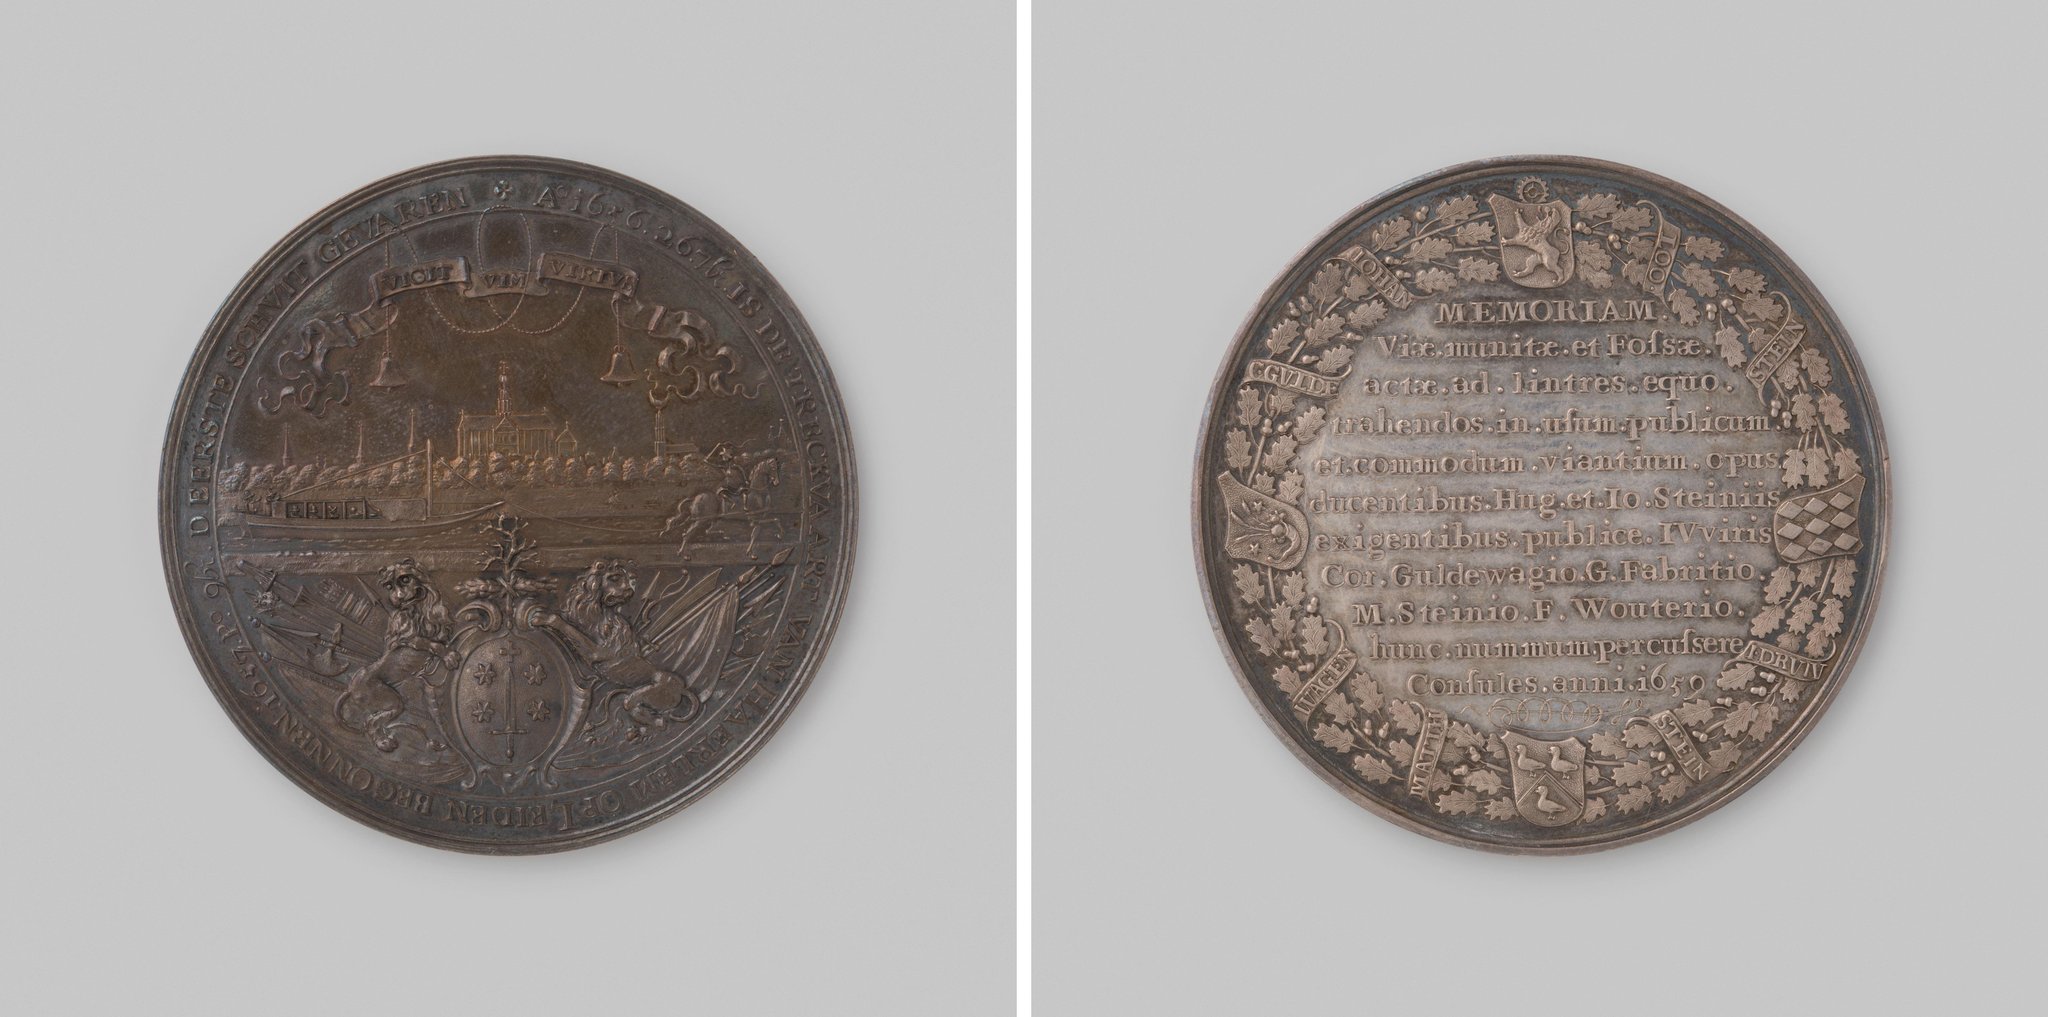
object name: history medal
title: Opening van de trekvaart van Haarlem naar Leiden 1657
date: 1657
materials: silver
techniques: striking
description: Zilveren penning, op de voorzijde een gezicht op de trekvaart bij Haarlem, op de voorgrond het wapen van Haarlem met leeuwen als dragers te midden van trofeeen en boven een lint met de wapenspreuk en twee Damiaatjes, met omschrift, op de keerzijde elf egels tekst binnen een eikenkrans waarop vier wapenschilden en een lint met tekst.